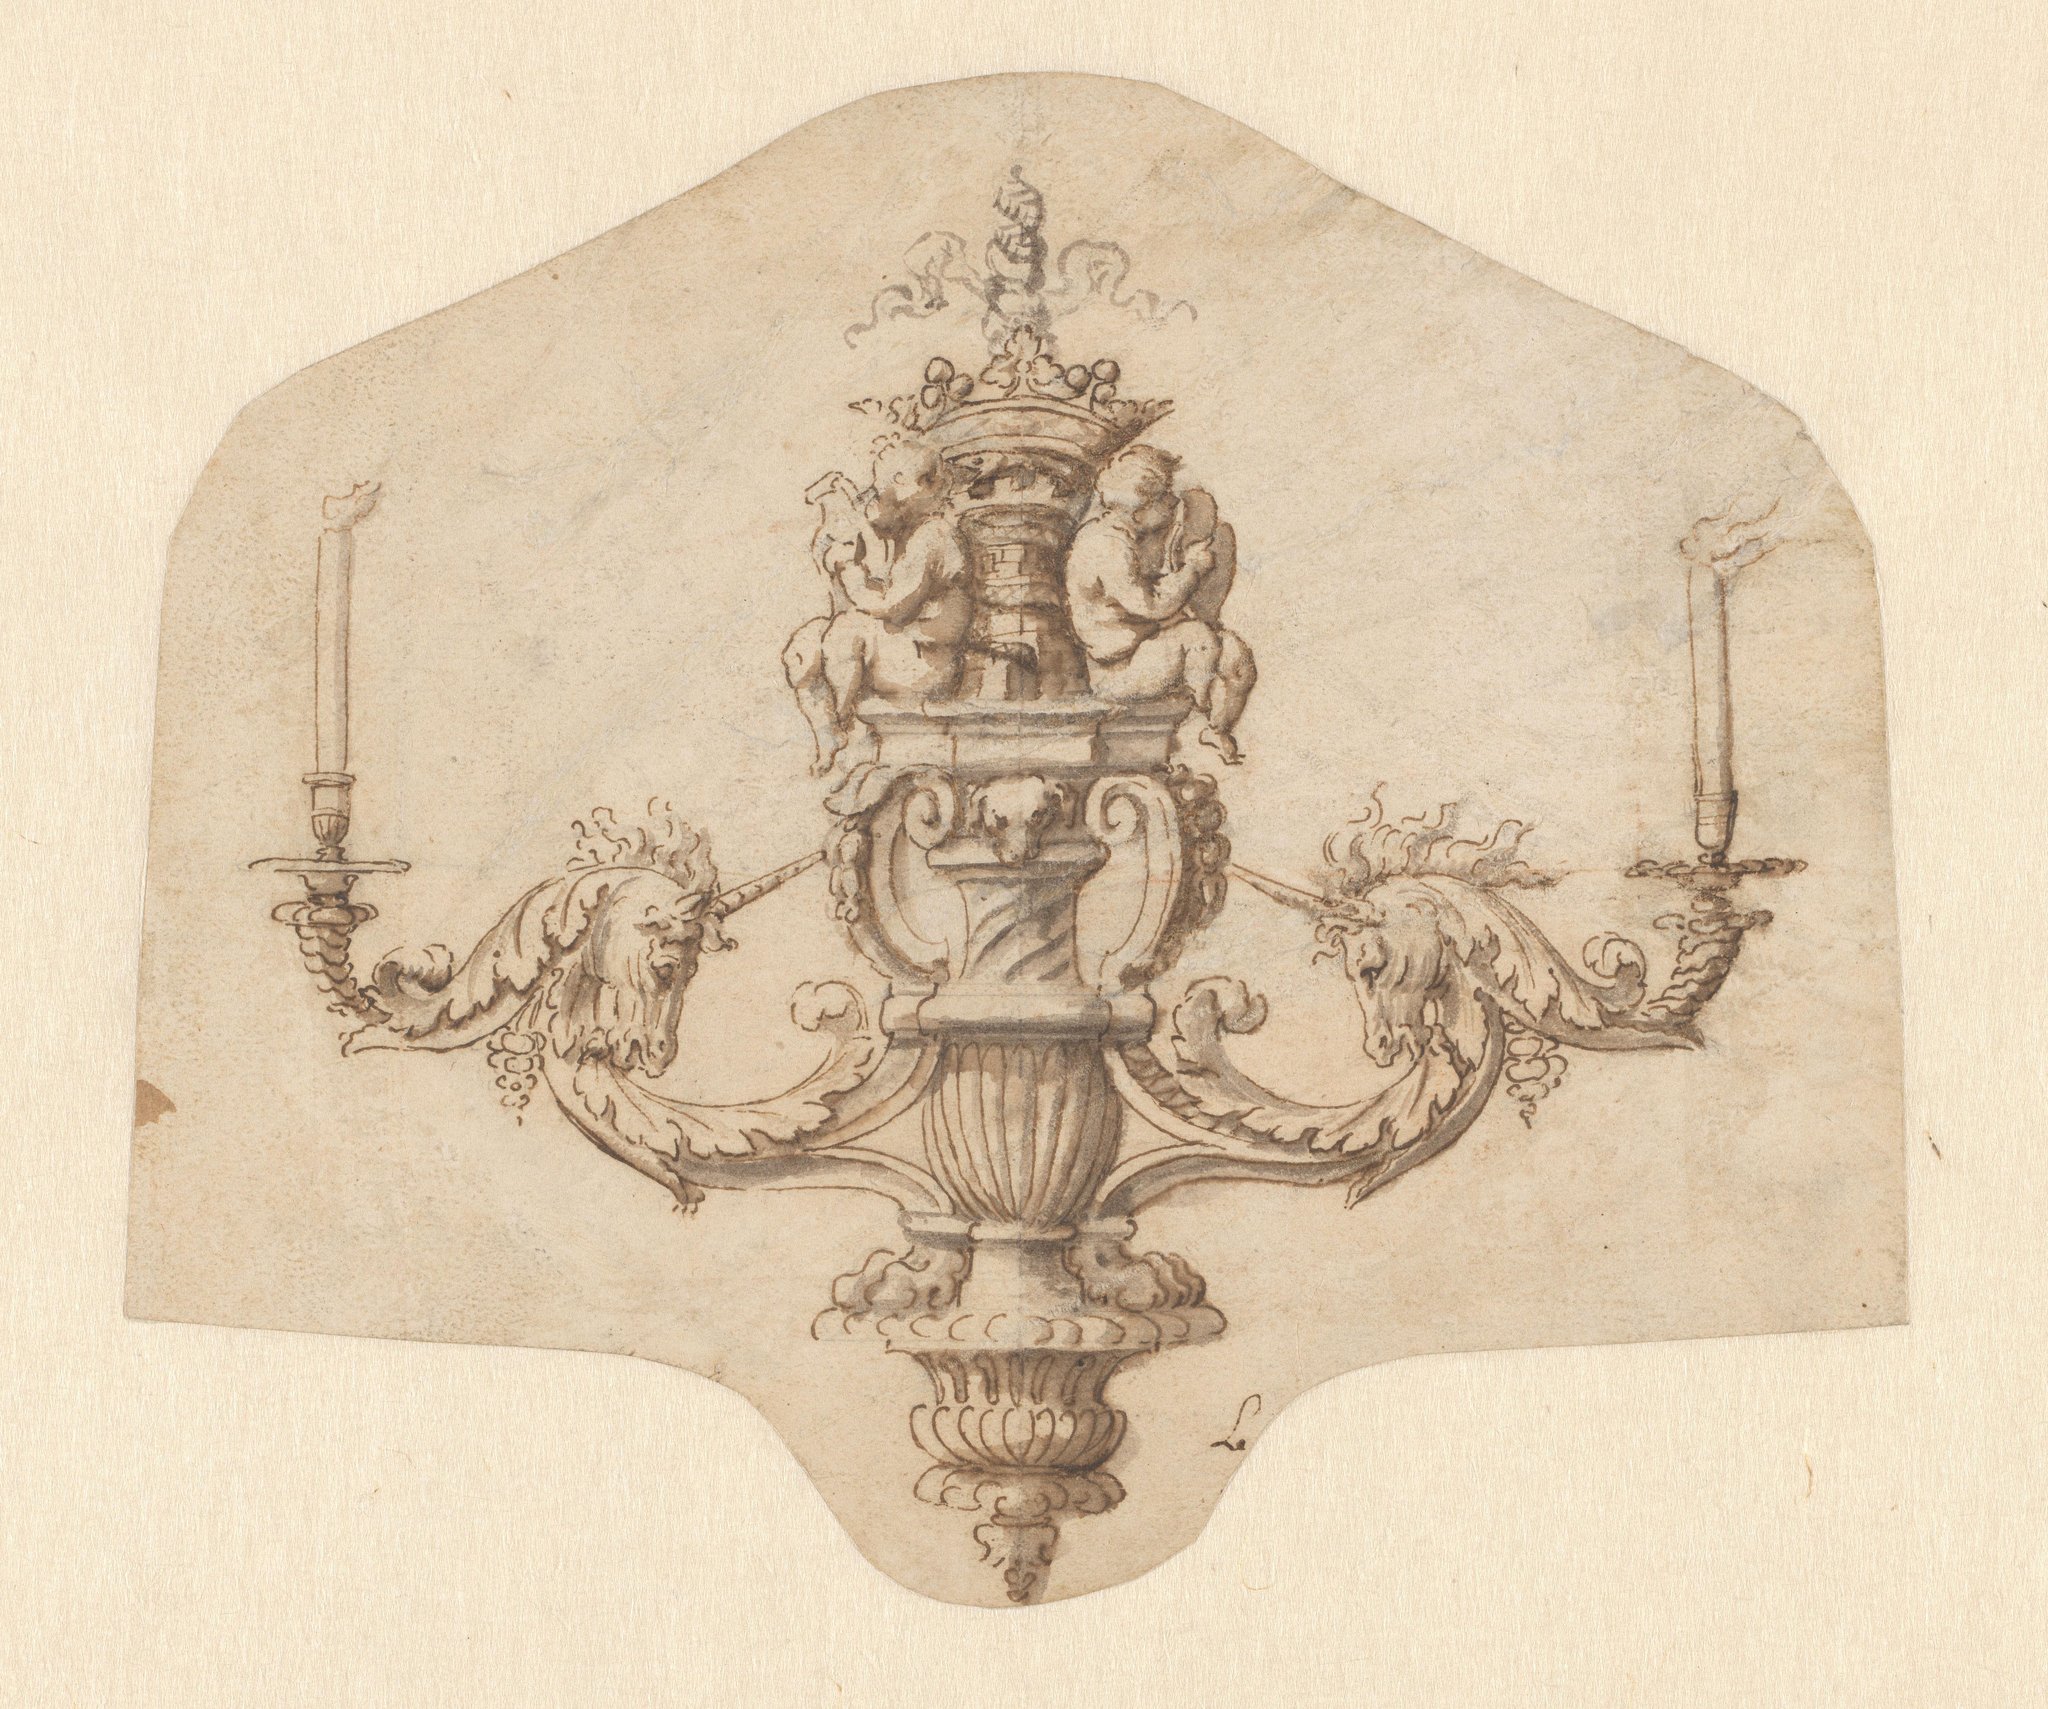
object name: design drawing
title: Ontwerp voor een zilveren kroonluchter voor een lid van de familie Colbert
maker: nicolas delaunay (1646-1727)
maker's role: goldsmith, sculptor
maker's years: 1646-1727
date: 1680-1690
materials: graphite, ink, paper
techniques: brush, pen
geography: paris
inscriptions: inscription: ‘L[e...]’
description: Daaronder een plattegrond en rechts een zijaanzicht van rechts en een doorsnede vanaf de linkerzijde. Onder het zijaanzicht een maatstaf.